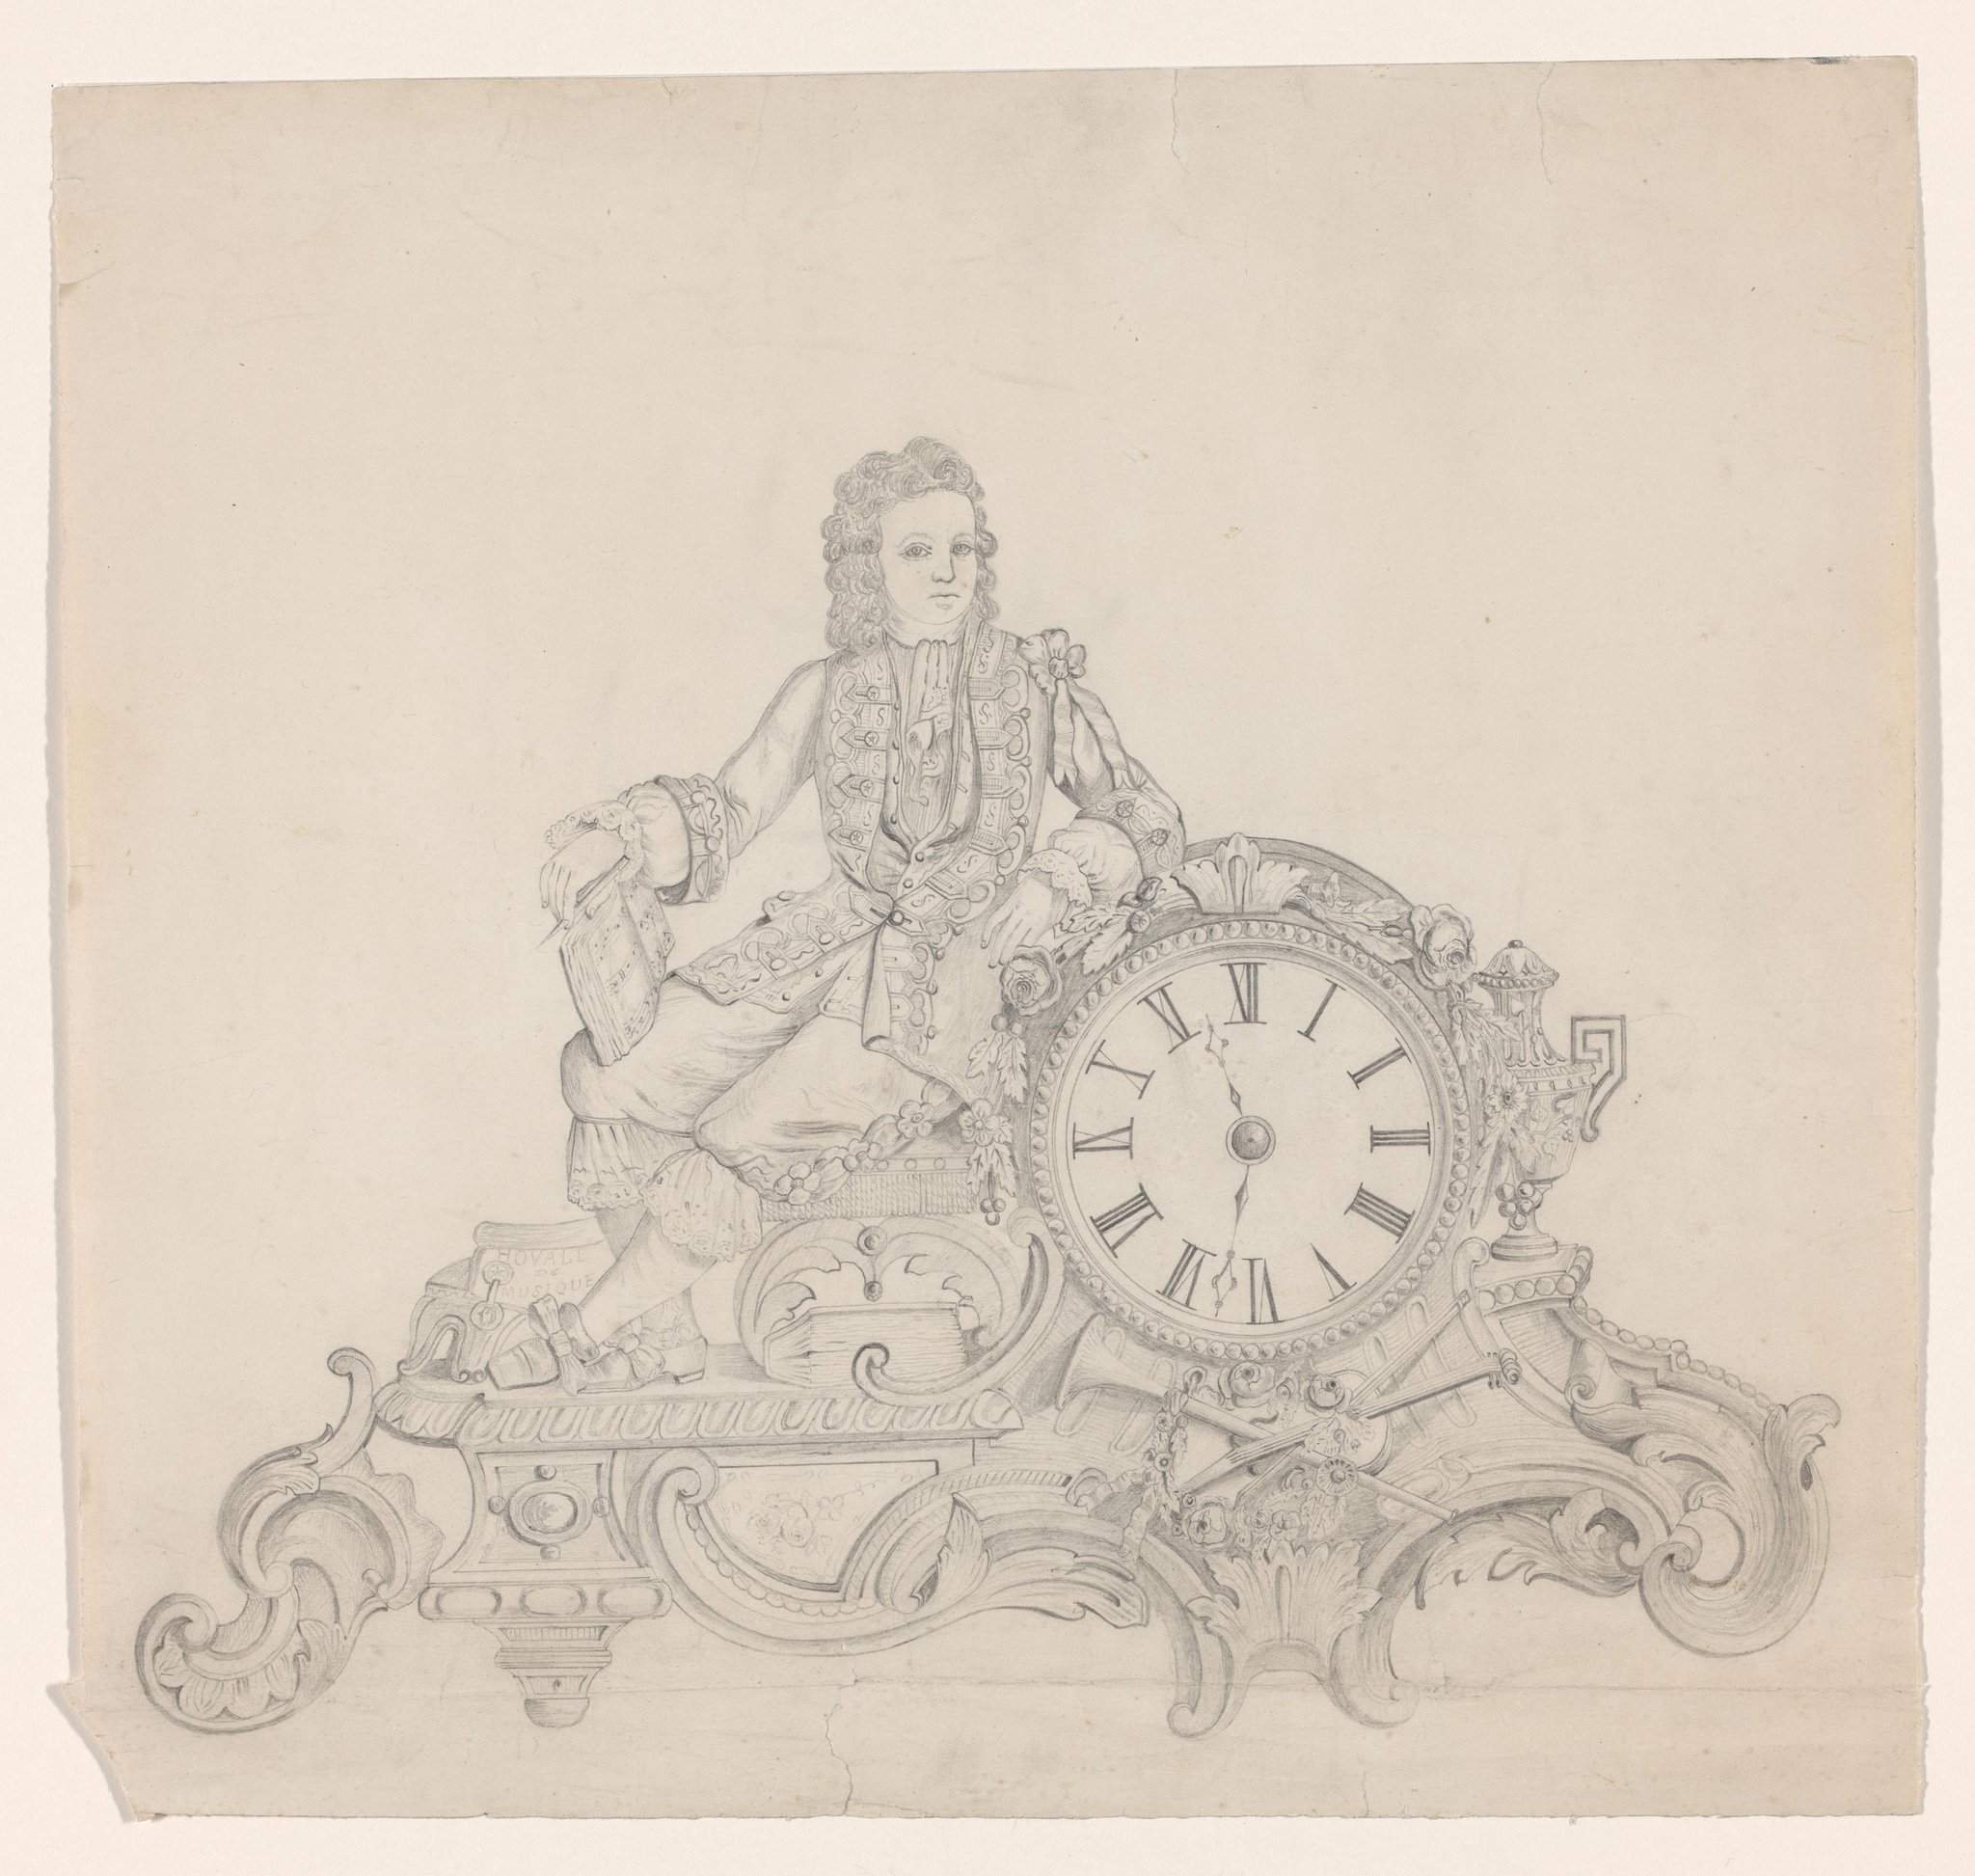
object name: design drawing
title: Ontwerp voor een pendule in neo-rococostijl met een componist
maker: Anonymous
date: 1850-1875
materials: graphite, paper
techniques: drawing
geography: paris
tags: clock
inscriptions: inscription: ‘Royale / de / Musique’